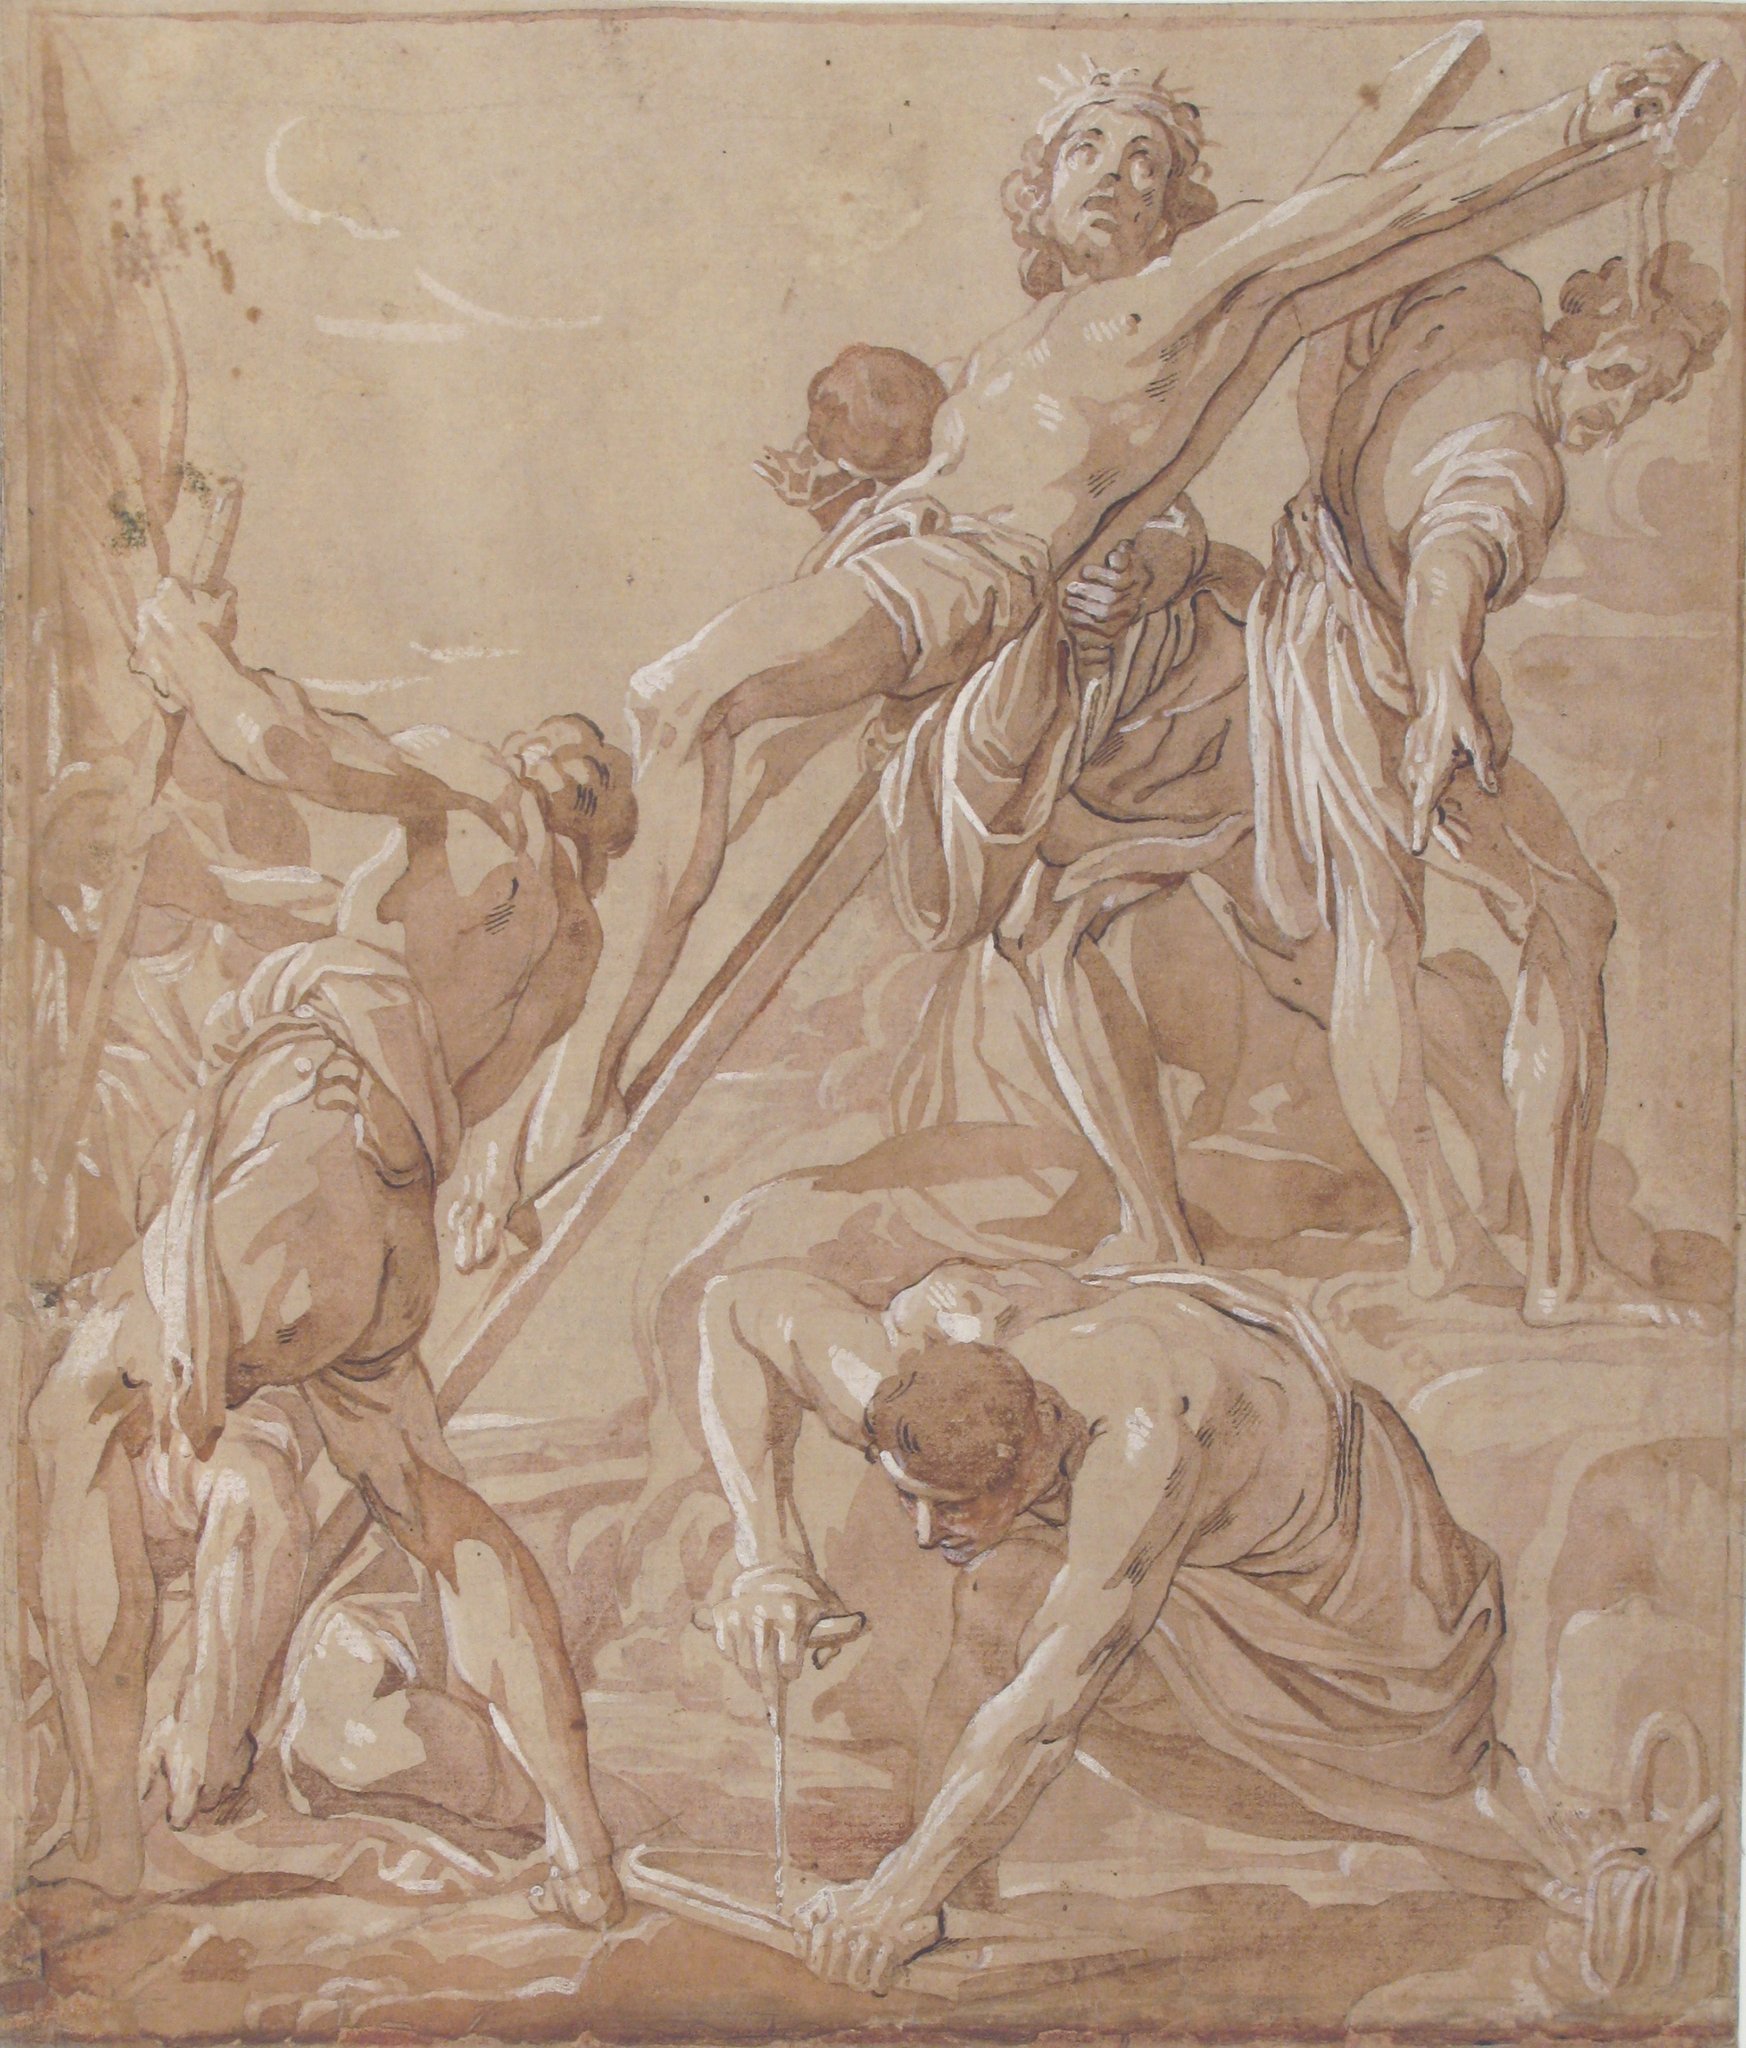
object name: drawing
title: Elevation of the Cross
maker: alessandro tiarini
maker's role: artist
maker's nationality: italian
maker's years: 1577-1668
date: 1577-1668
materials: ink, paper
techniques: highlighting, pen, wash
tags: men,christ,cross,crucifixion